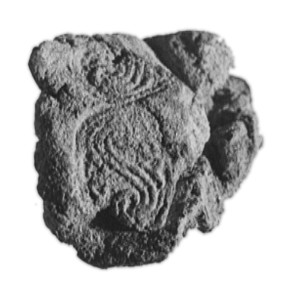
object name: sealing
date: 2030-1640 BCE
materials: clay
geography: egypt